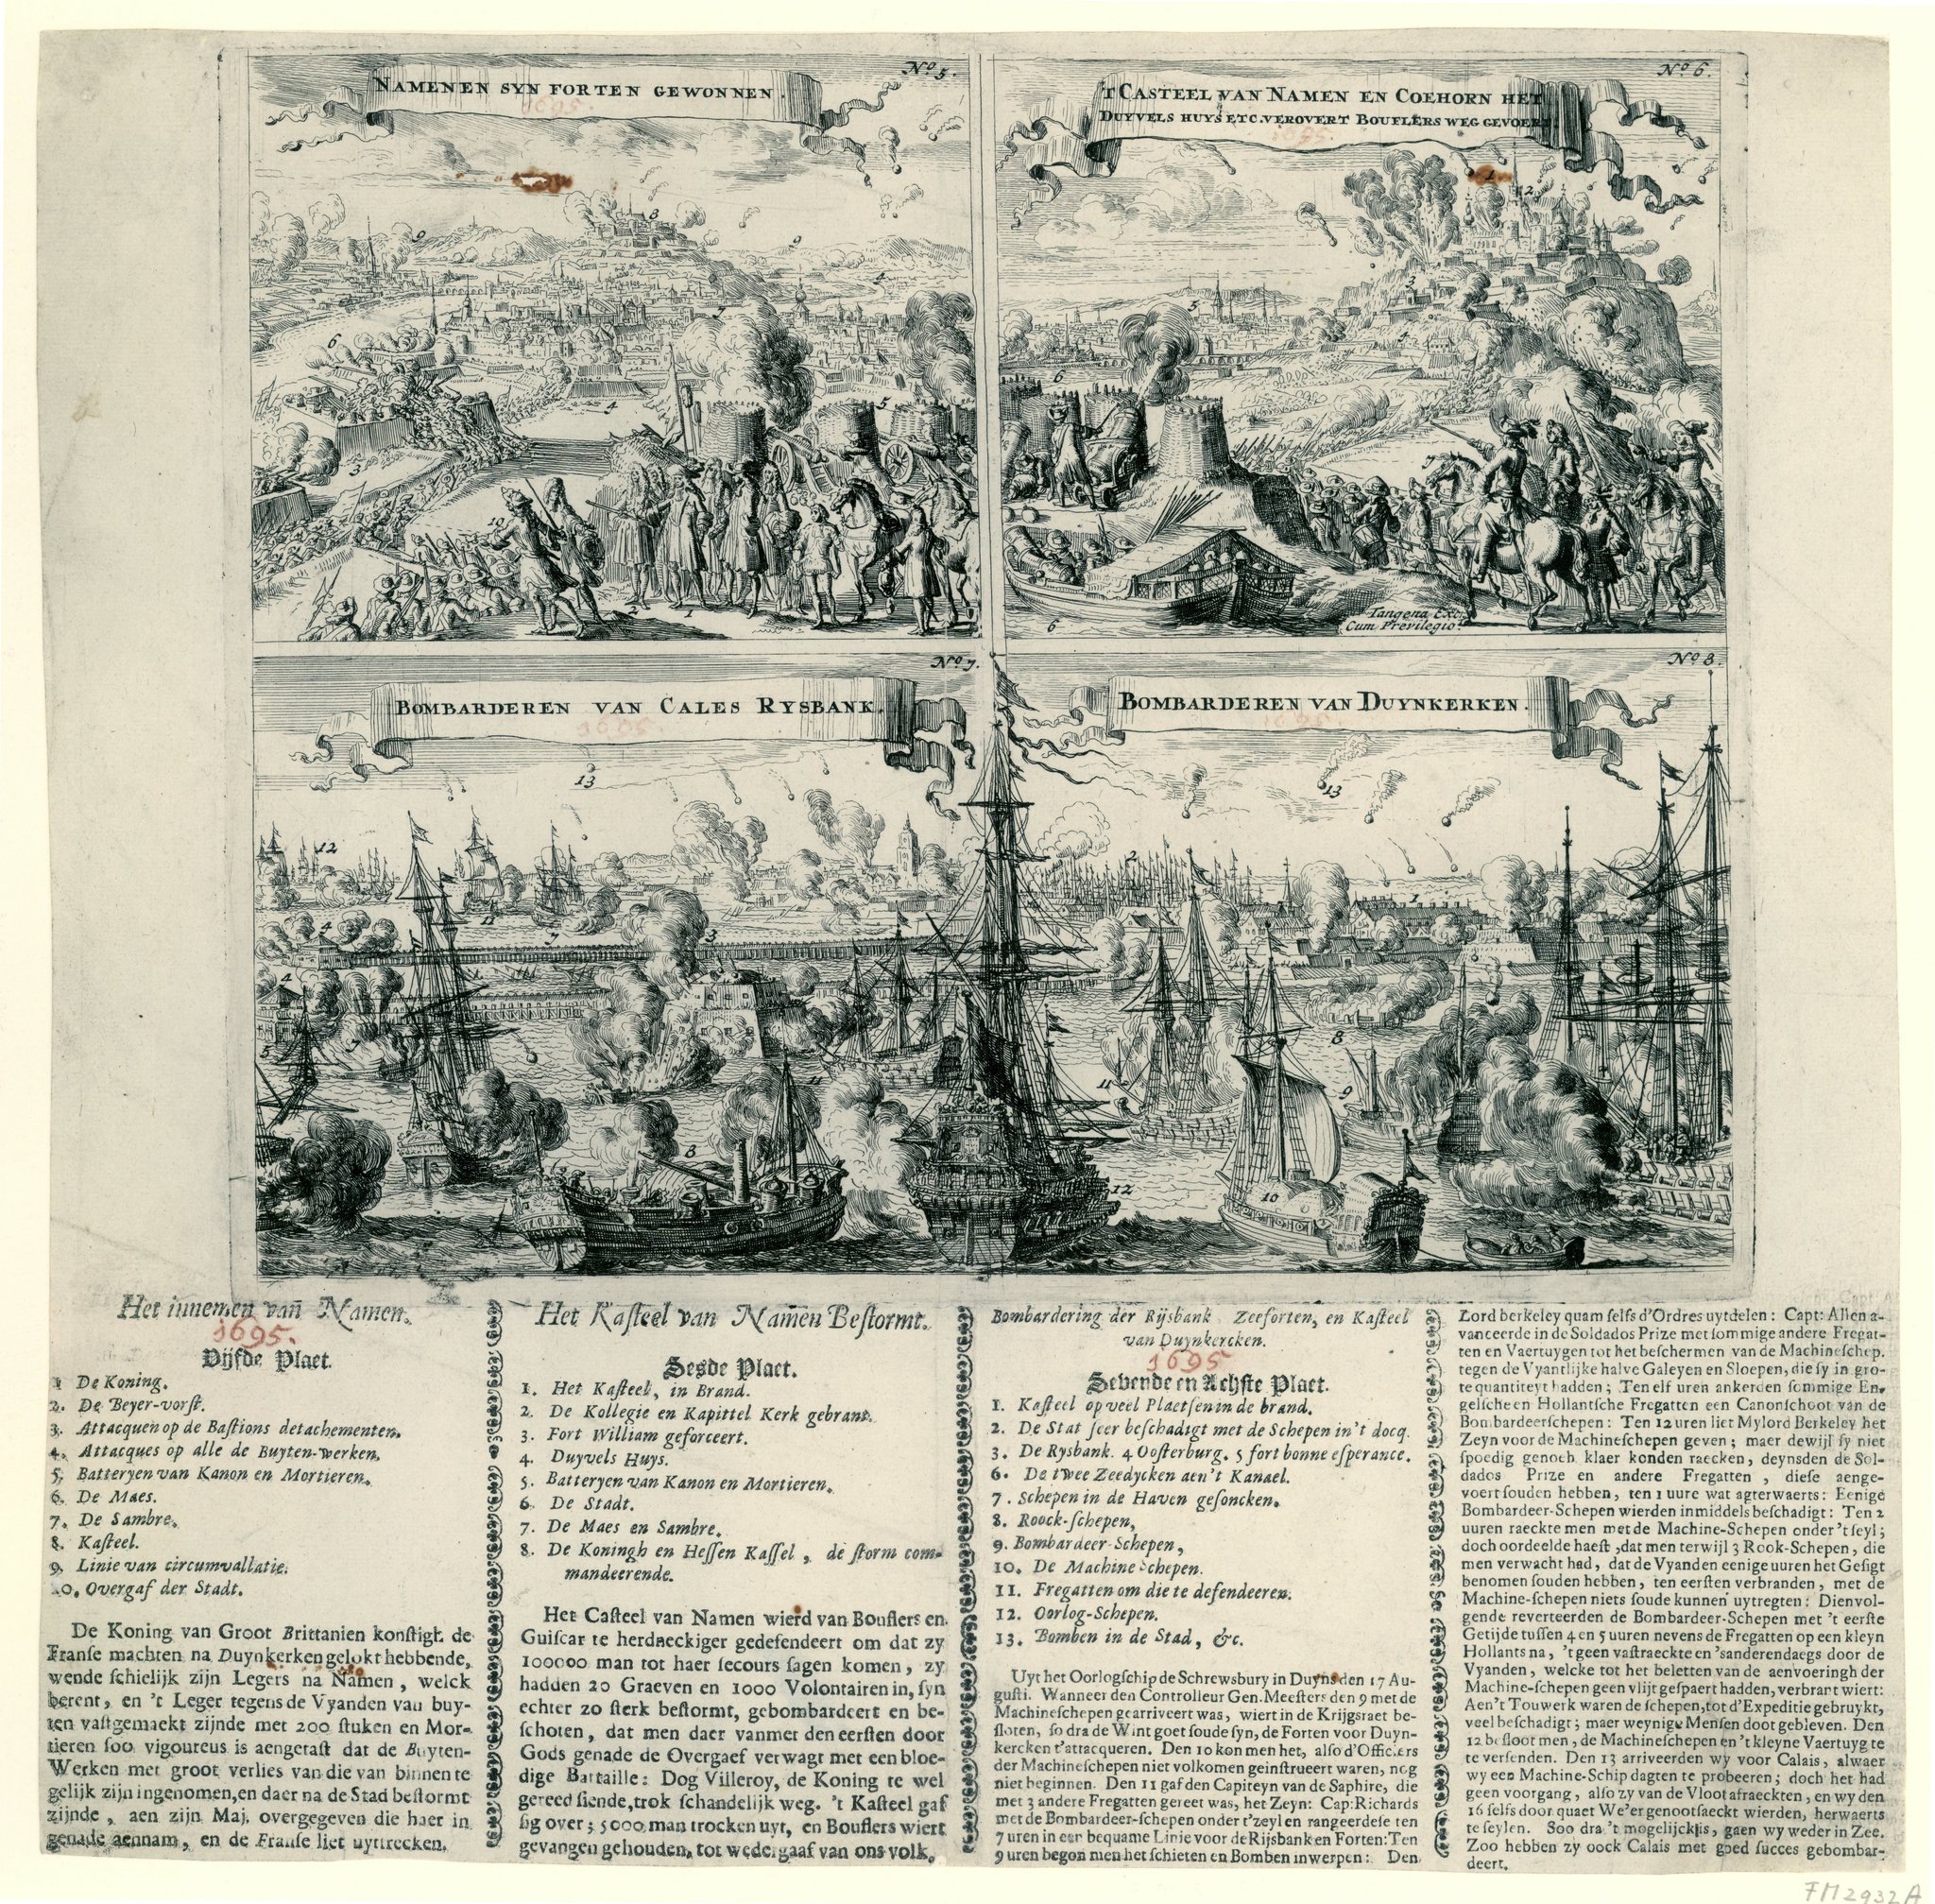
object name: print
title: Blad met vier platen van oorlogstaferelen uit 1695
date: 1695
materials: paper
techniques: etching, letterpress printing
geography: northern netherlands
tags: the hague, william iii (prince of orange and king of england, scotland, and ireland), siege, position war, bombardment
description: Blad met vier platen van het belegeren en bombarderen van steden in Franse handen door de geallieerden in 1695. De voorstelling is in vieren verdeeld, genummerd 5-8 en toont boven het beleg van Namen (nrs. 5-6) en onder het bombarderen van Calais (nr. 7) en Duinkerken (nr. 8). Onder de voorstellingen vier kolommen tekst met de beschrijvingen van de platen.